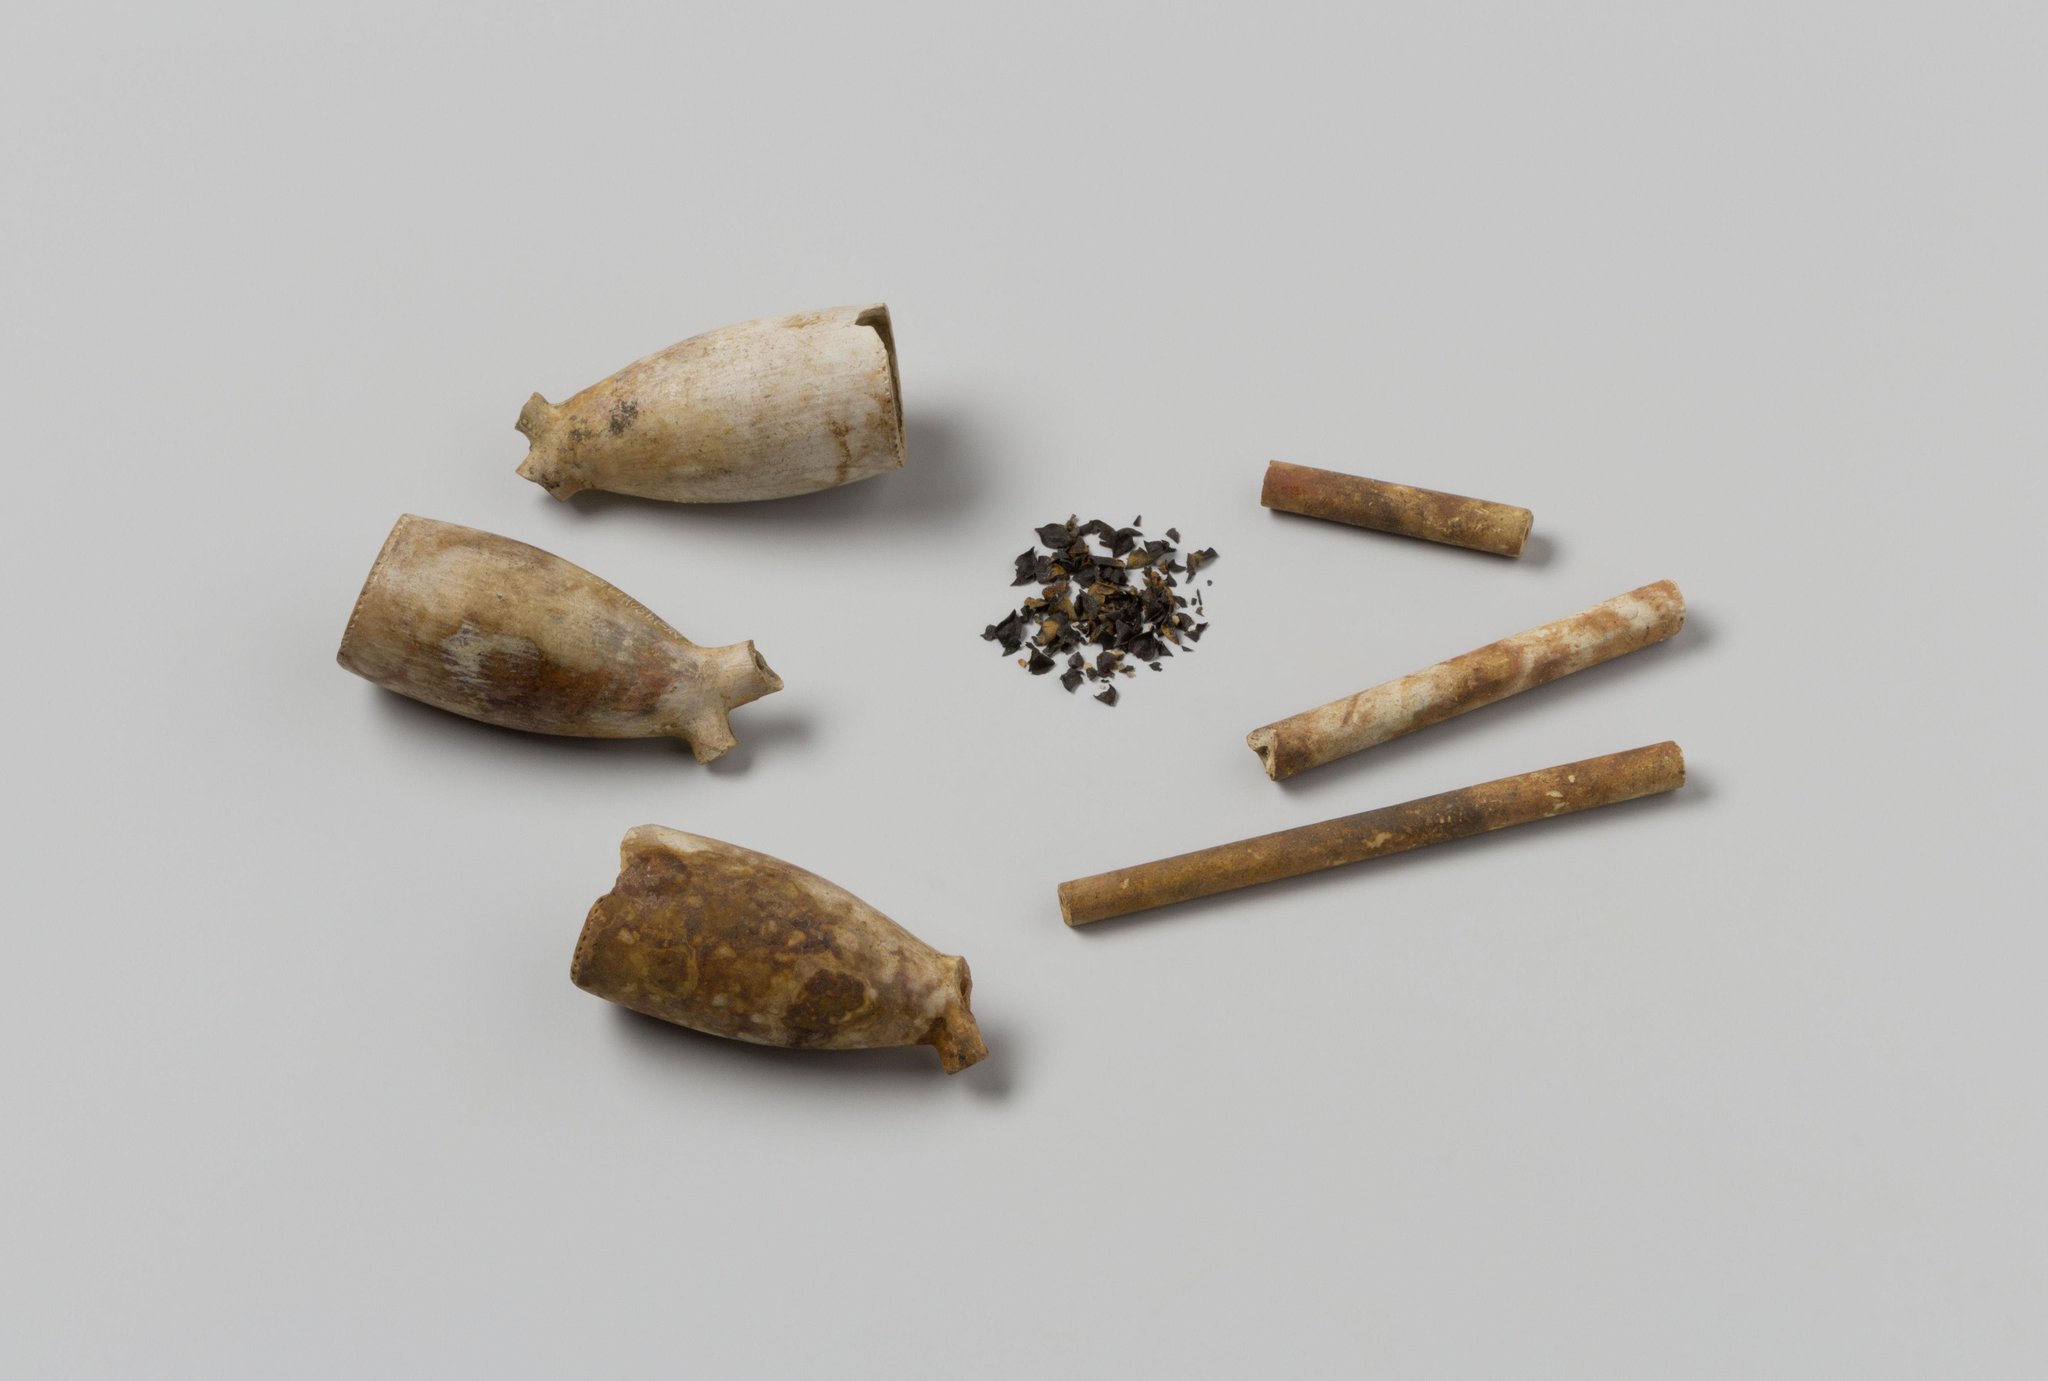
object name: pipe bowl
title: Fragment pijpenkoppen en pijpenstelen uit het wrak van de Oost-Indiëvaarder Hollandia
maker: Anonymous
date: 1700-1743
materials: clay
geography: netherlands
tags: verenigde oostindische compagnie, hollandia (schip), annet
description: Pipe, bowl, heelmark: crowned 57; no hsm, 1hsm1, 2hsm1,2.